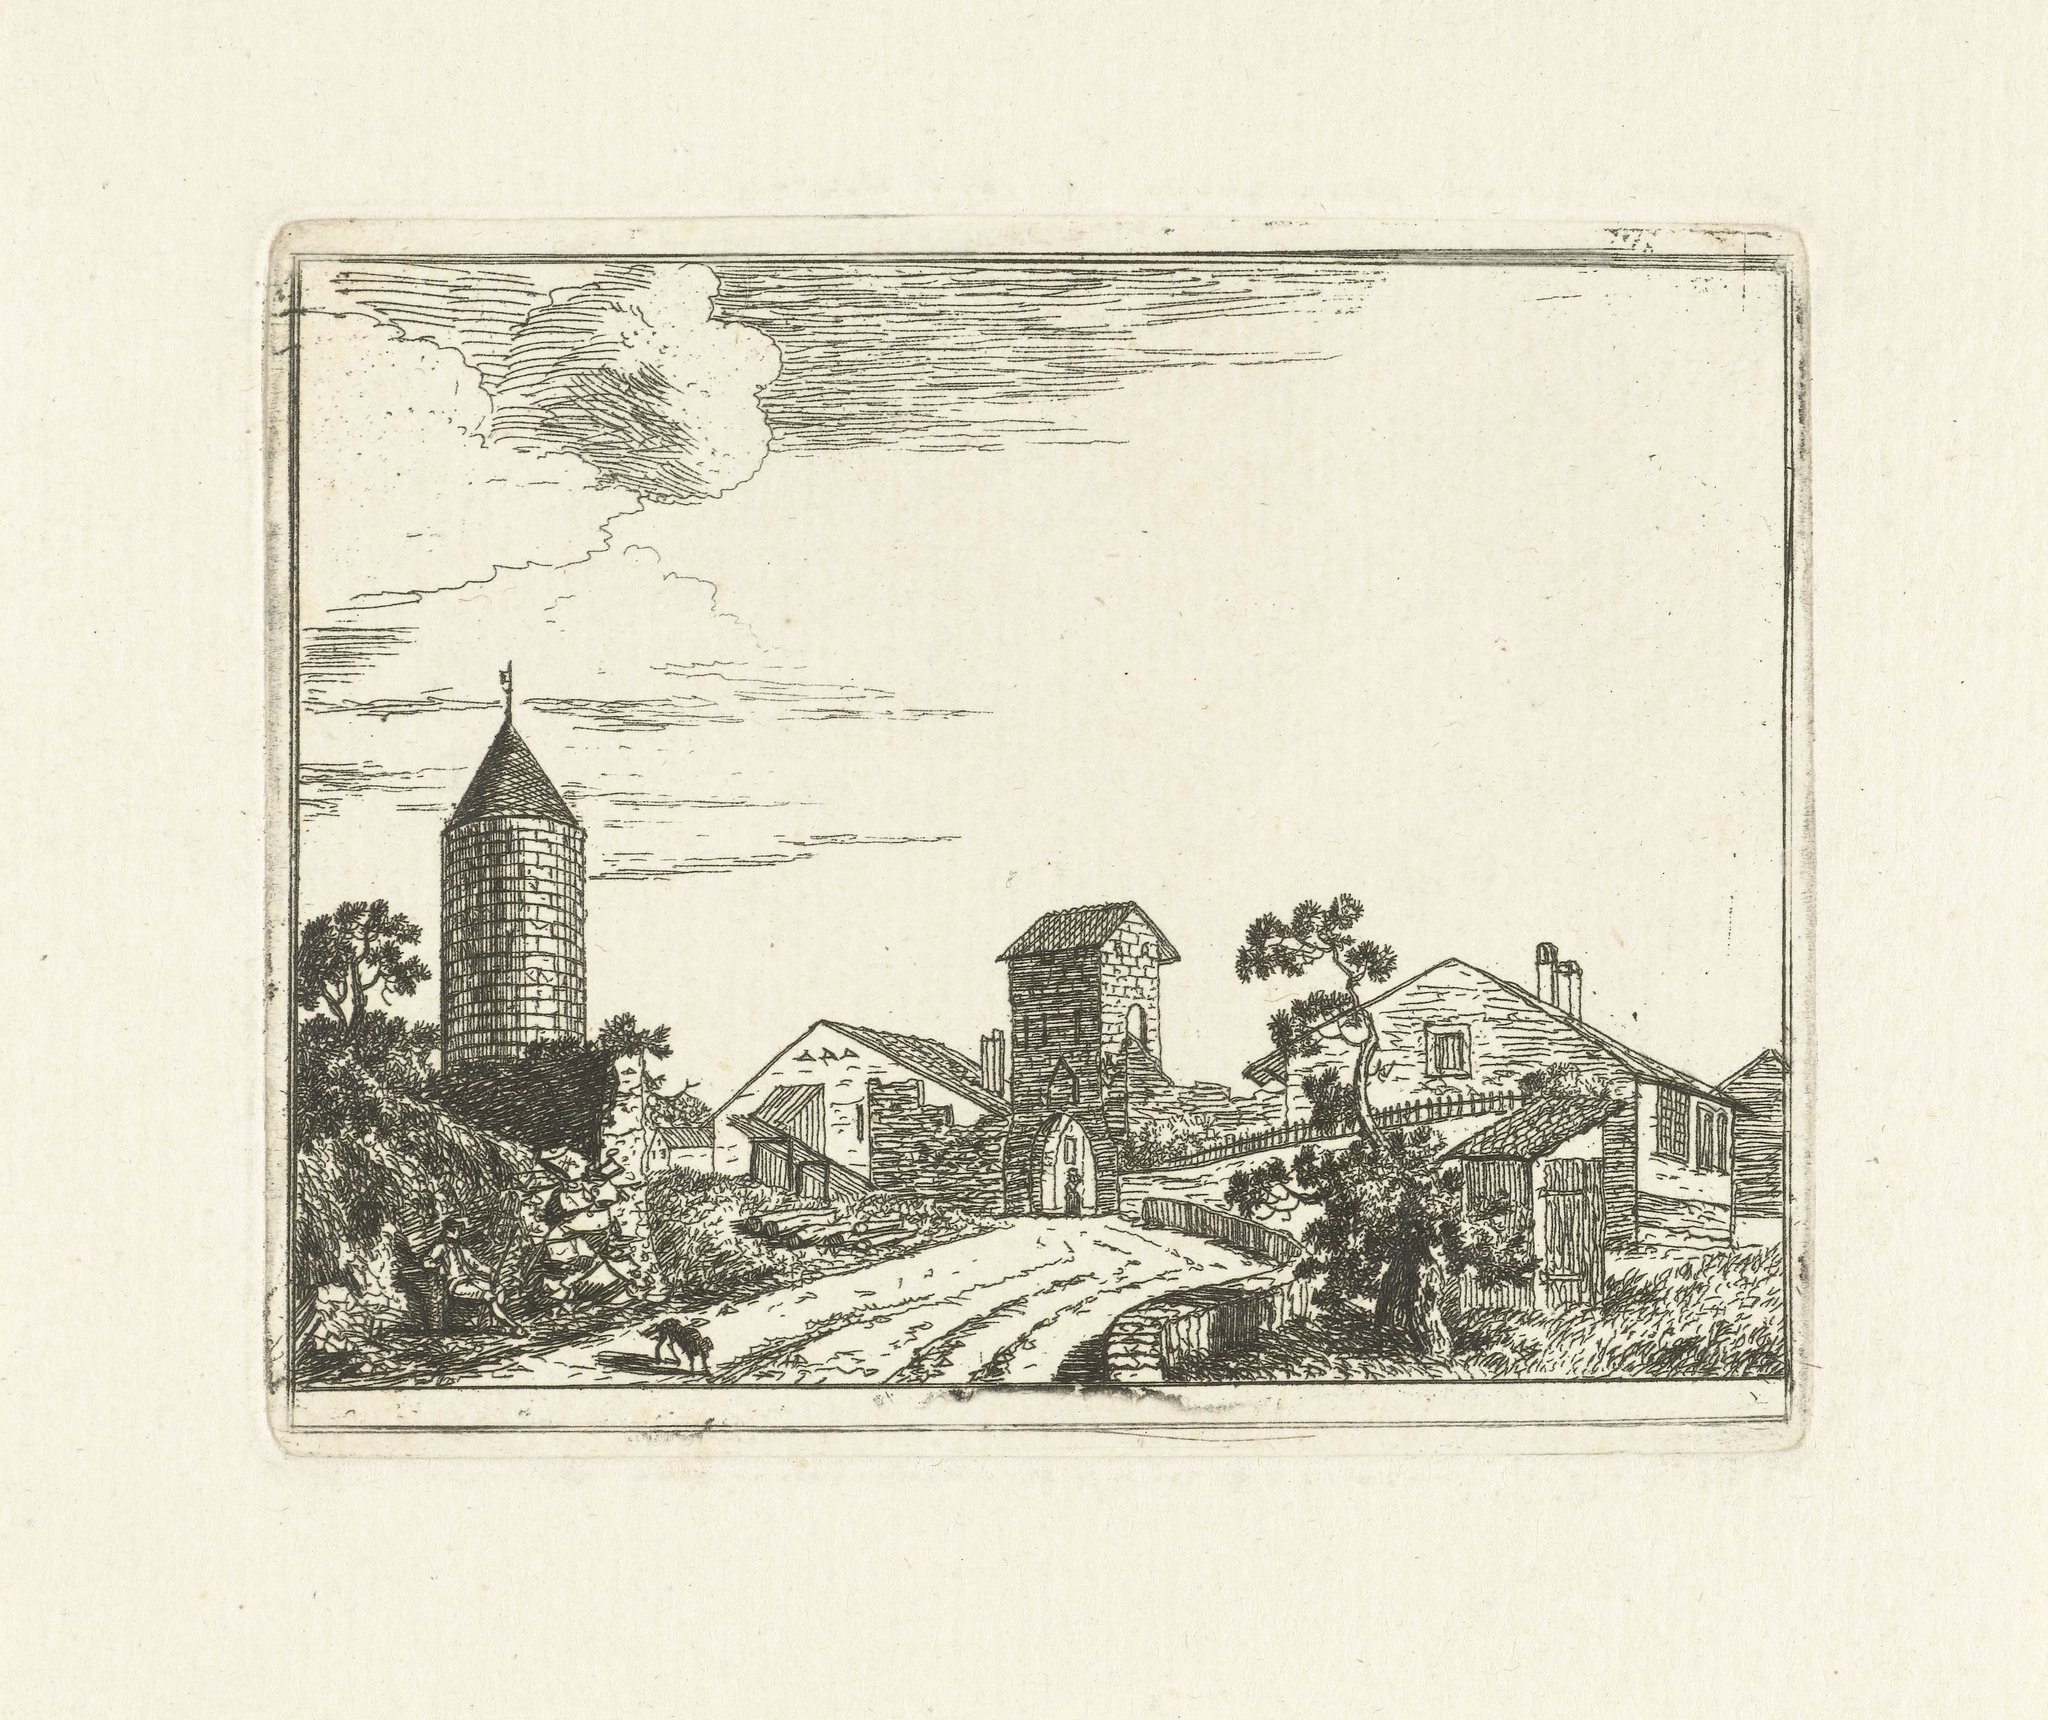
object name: print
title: Gezicht op een stadspoort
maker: daniël dupré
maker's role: draughtsman, print maker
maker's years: 1751-1817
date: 1771-1817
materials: paper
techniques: etching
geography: netherlands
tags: city-view, and landscape with man-made constructions, farm or solitary house in landscape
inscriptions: collector's mark: Lugt 240